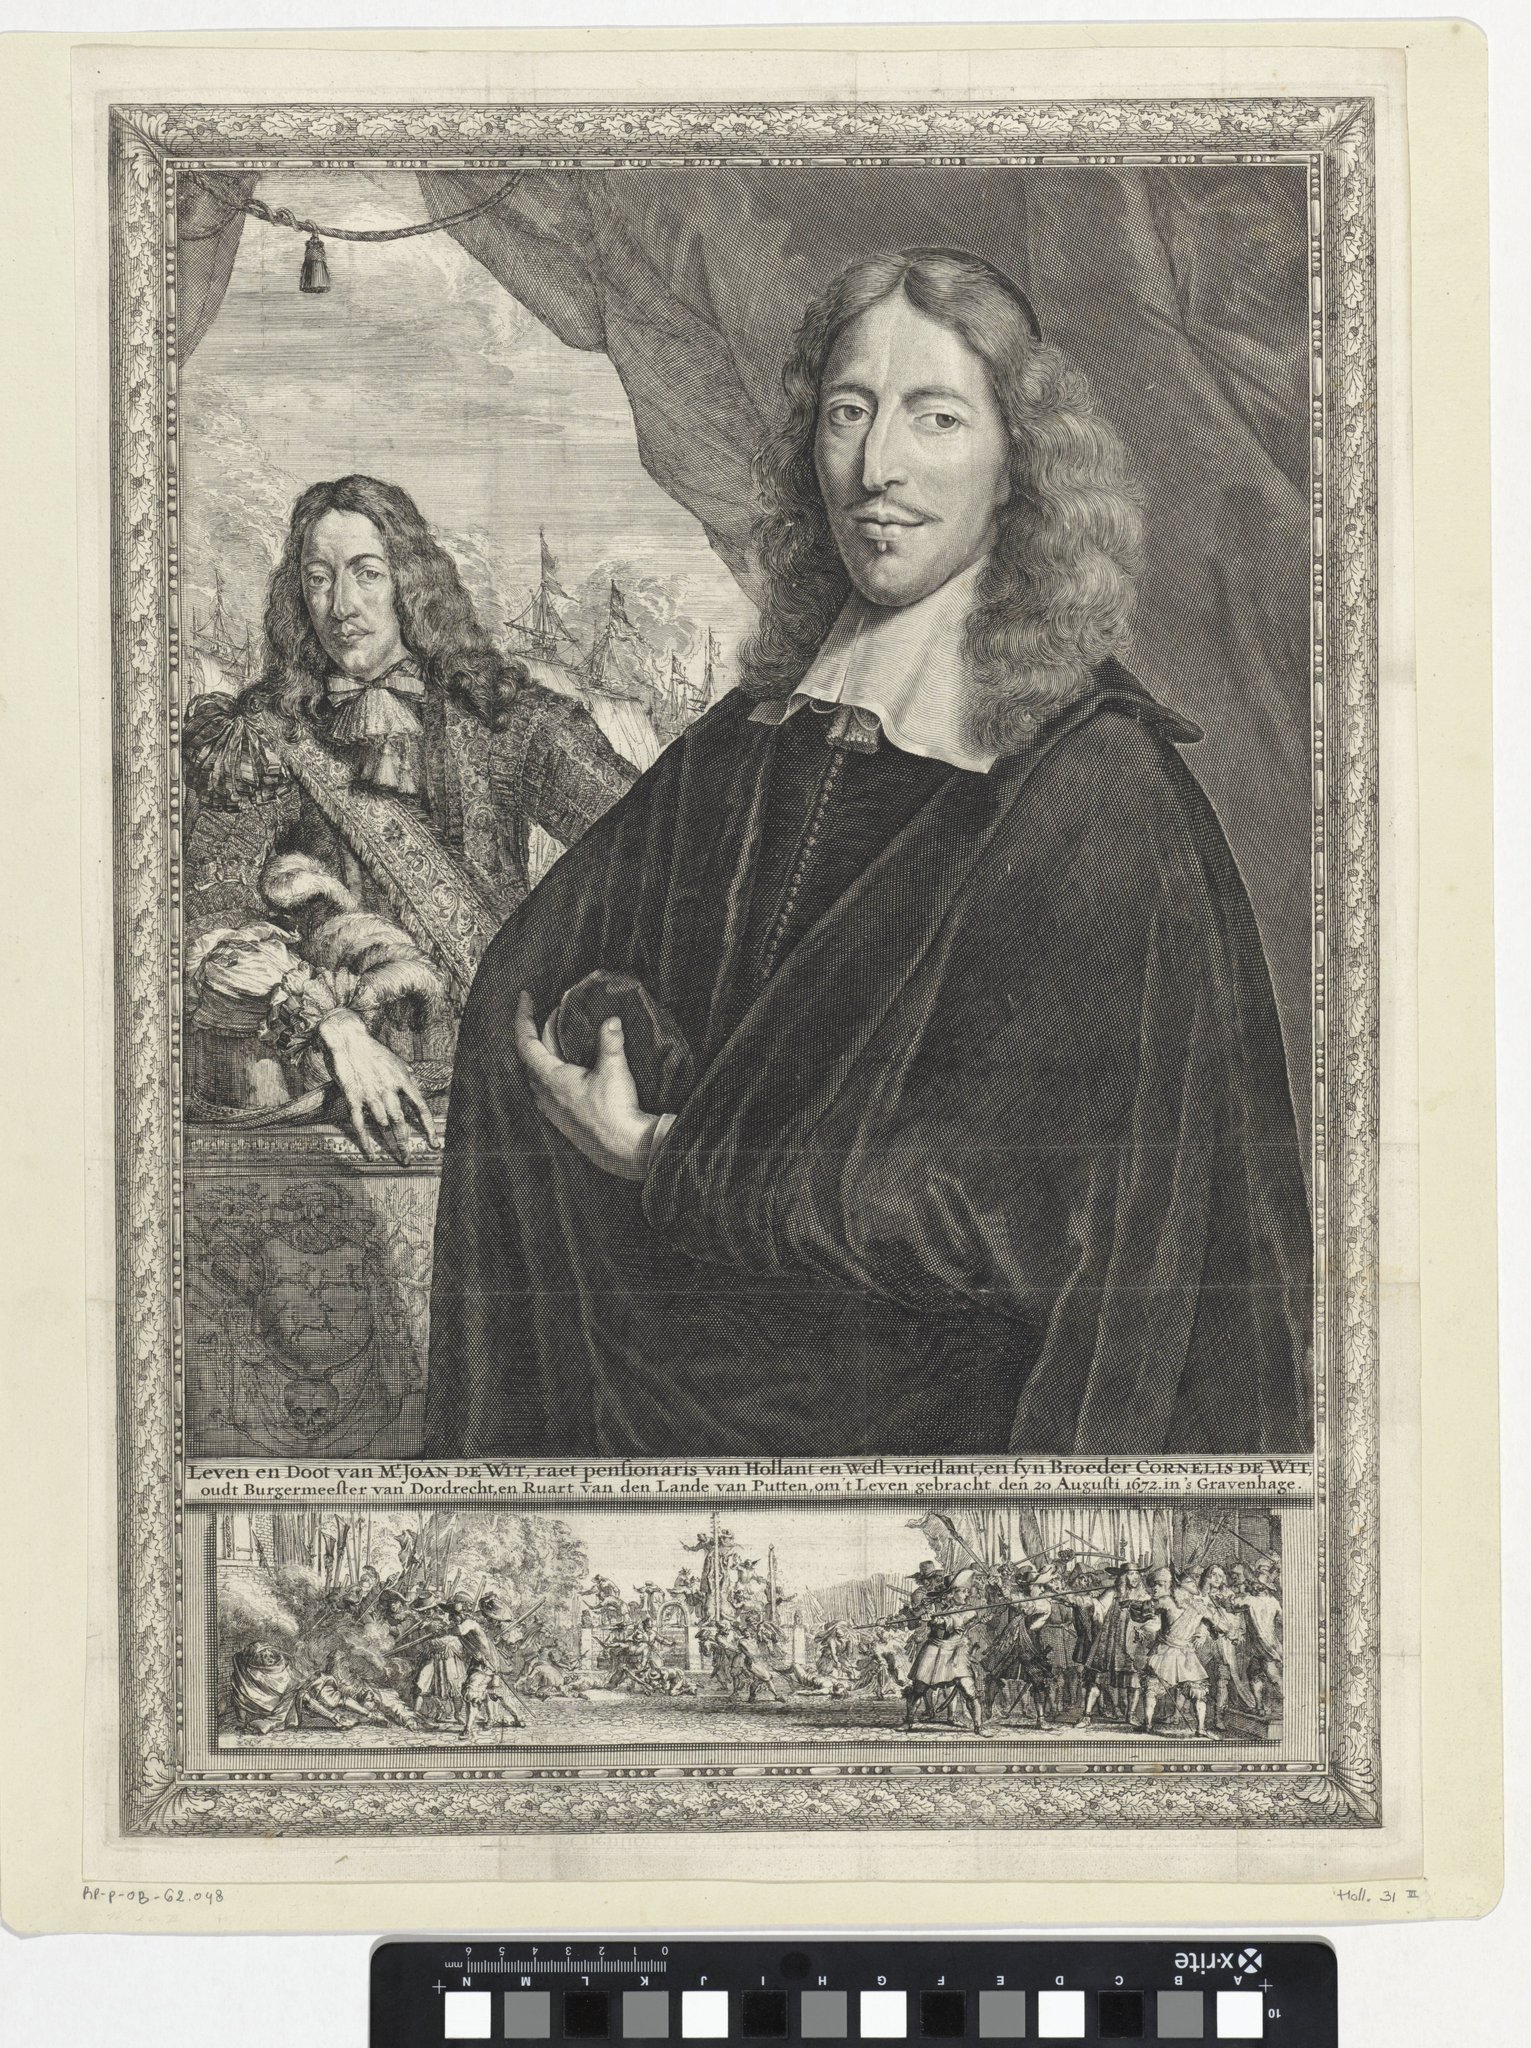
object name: print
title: Portret van Johan de Witt en Cornelis de Witt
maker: lambert visscher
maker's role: draughtsman, print maker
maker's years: 1640-1679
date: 1672-1691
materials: paper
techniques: engraving, etching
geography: northern netherlands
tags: dordrecht, the hague, cornelis de witt, johan de witt, ships (in general), violent death, being killed; being mishandled and maltreated; seeking death (+ death by lynching)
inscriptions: collector's mark: Lugt 240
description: Portret van de advocaat Johan de Witt, raadpensionaris van het gewest Holland. Hij is gekleed in een mantel en staat voor een gordijn, waarachter zijn broer Cornelis de Witt. Onder het portret een afbeelding waar te zien is hoe de lichamen van de gebroeders op het Groene Zoodje worden opgehangen en verminkt.